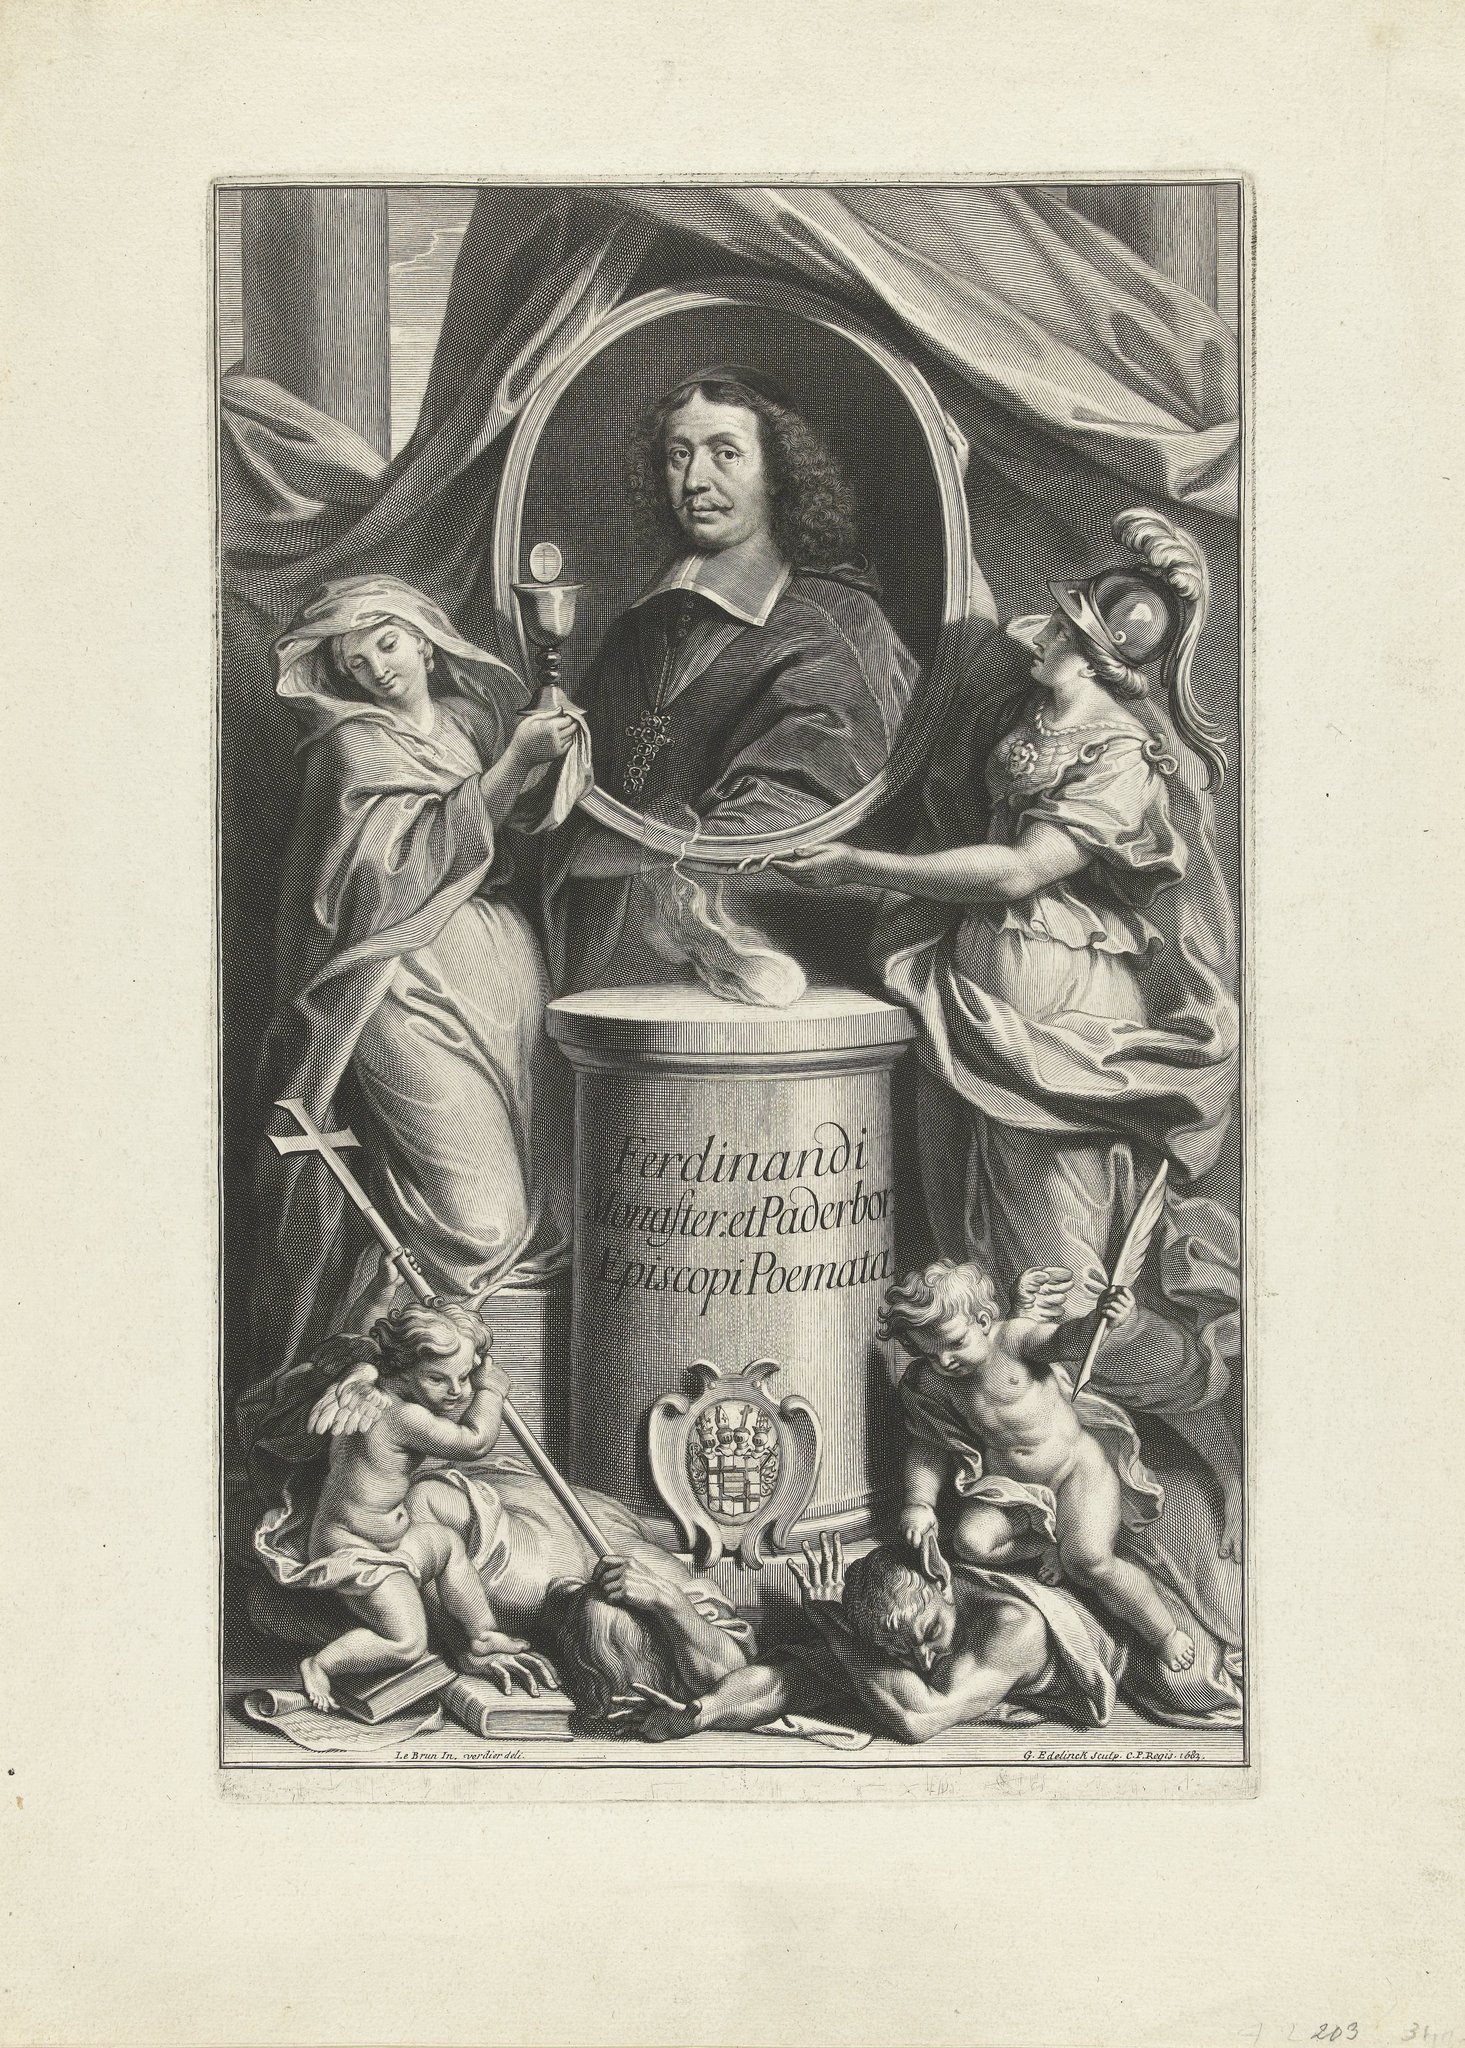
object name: print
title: Portret van Ferdinand von Fürstenberg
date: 1683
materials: paper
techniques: engraving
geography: france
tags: ferdinand van fürstenberg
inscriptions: collector's mark: Lugt 240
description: Portret van Ferdinand von Fürstenberg (1626-1683), in ovale lijst boven een altaar met wapen. De lijst wordt vastgehouden door twee vrouwen: Minerva en de personificatie van religie. Op de voorgrond worden twee mannen, personificaties van Ongeloof en Onwetendheid, door twee putti op de grond gedrukt.